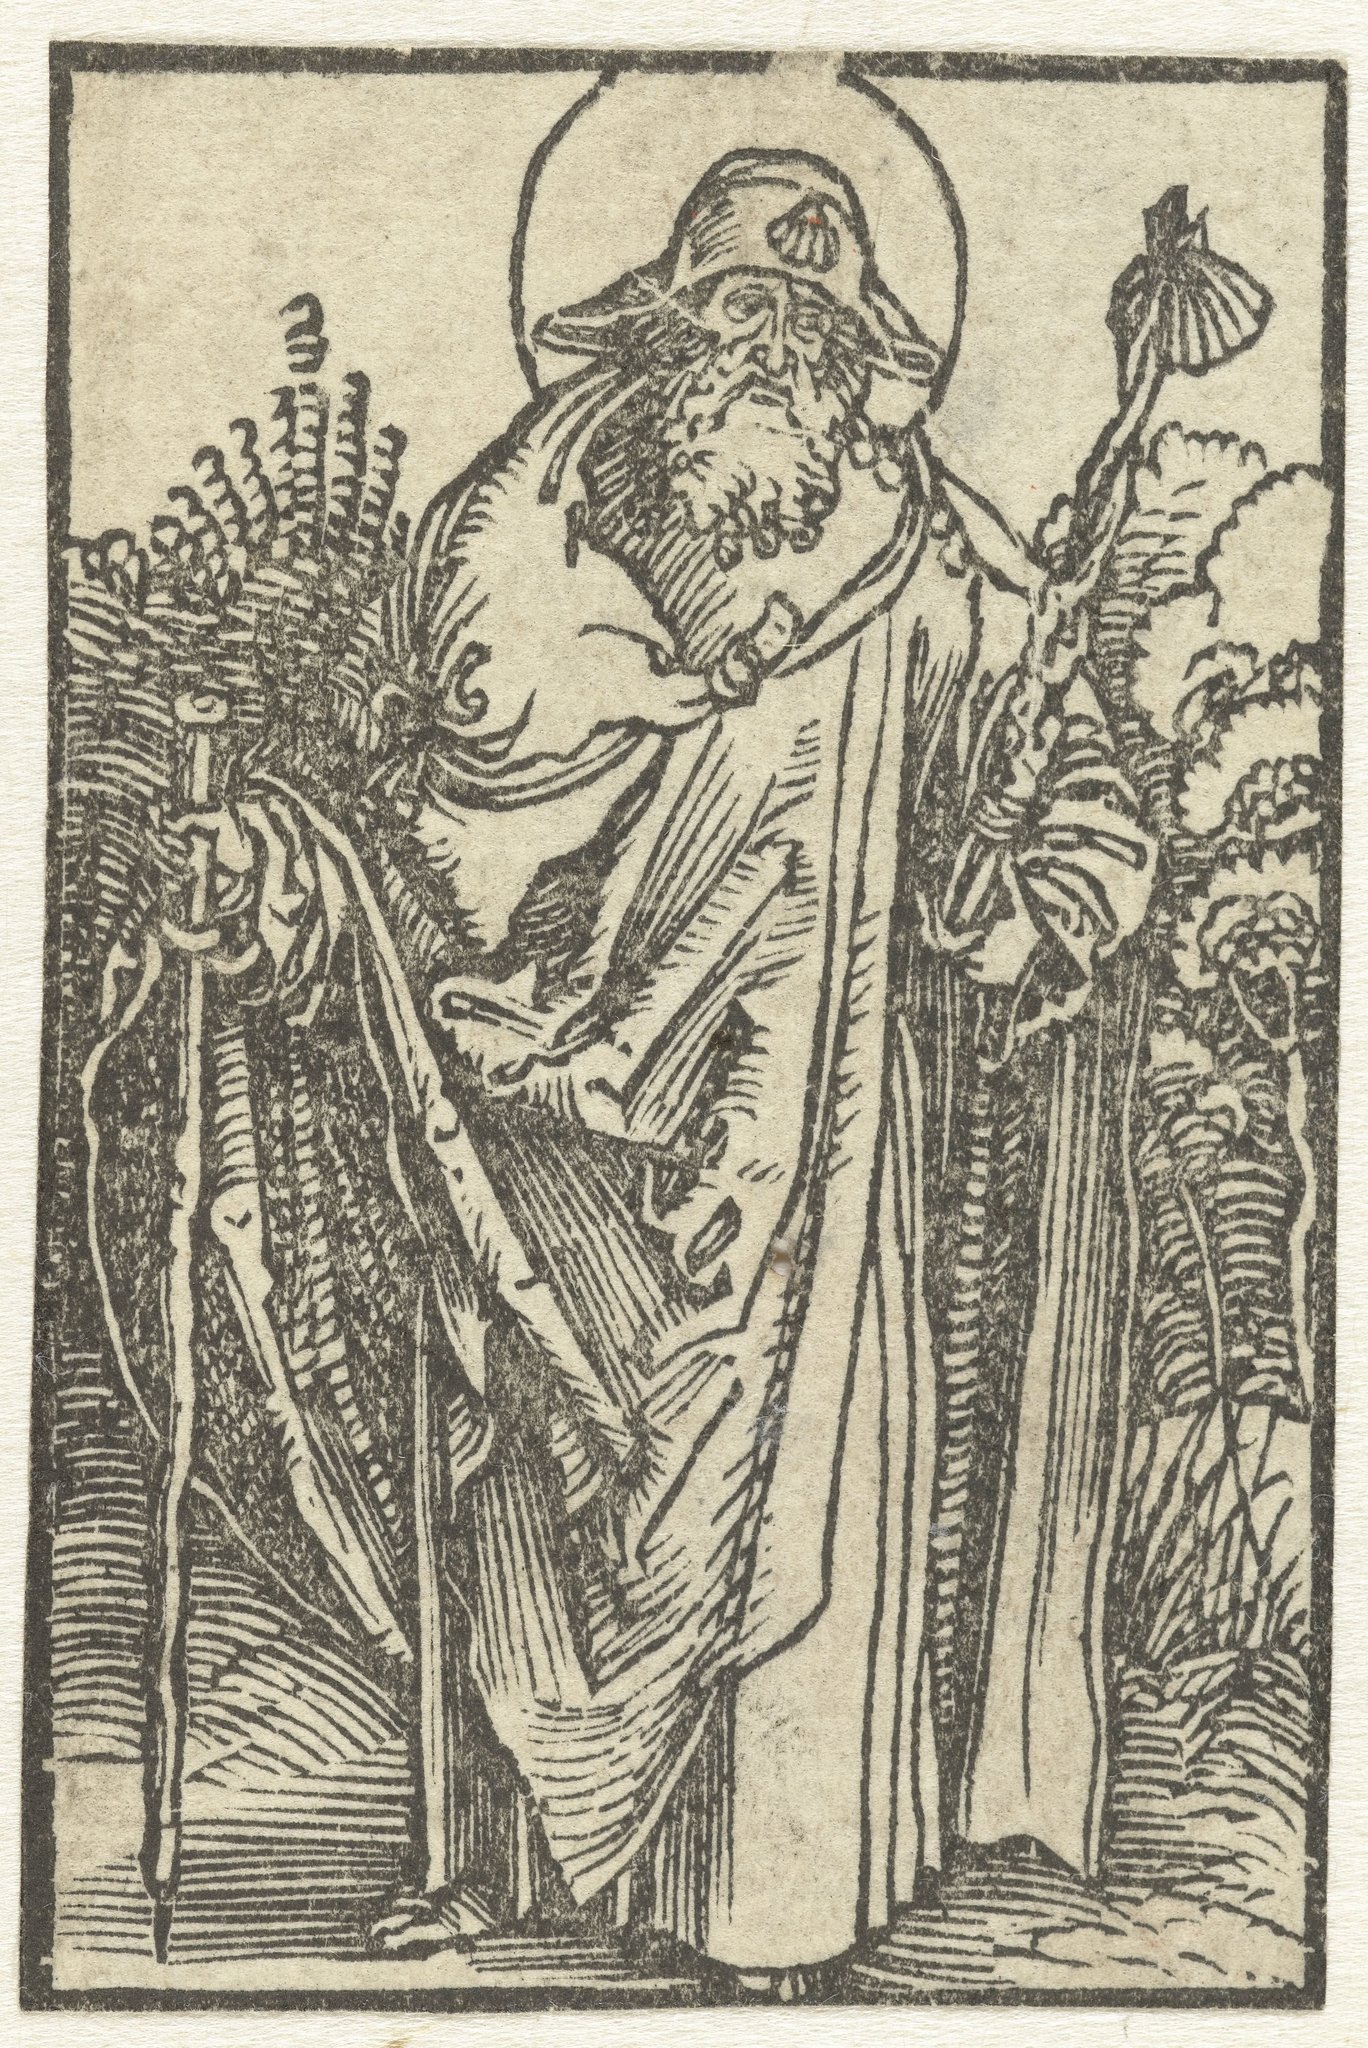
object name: print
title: Apostel Jakobus de Meerdere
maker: albrecht dürer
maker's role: draughtsman, painter, print maker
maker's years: 1471-1528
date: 1503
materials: paper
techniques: woodcut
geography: nuremberg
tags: the apostle james the great; possible attributes: book, pilgrim's cloak, hat, shell, staff, and wallet, scroll, sword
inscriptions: collector's mark: Lugt 240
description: De apostel Jakobus de Meerdere met een hoed op het hoofd en een wandelstok in de hand.